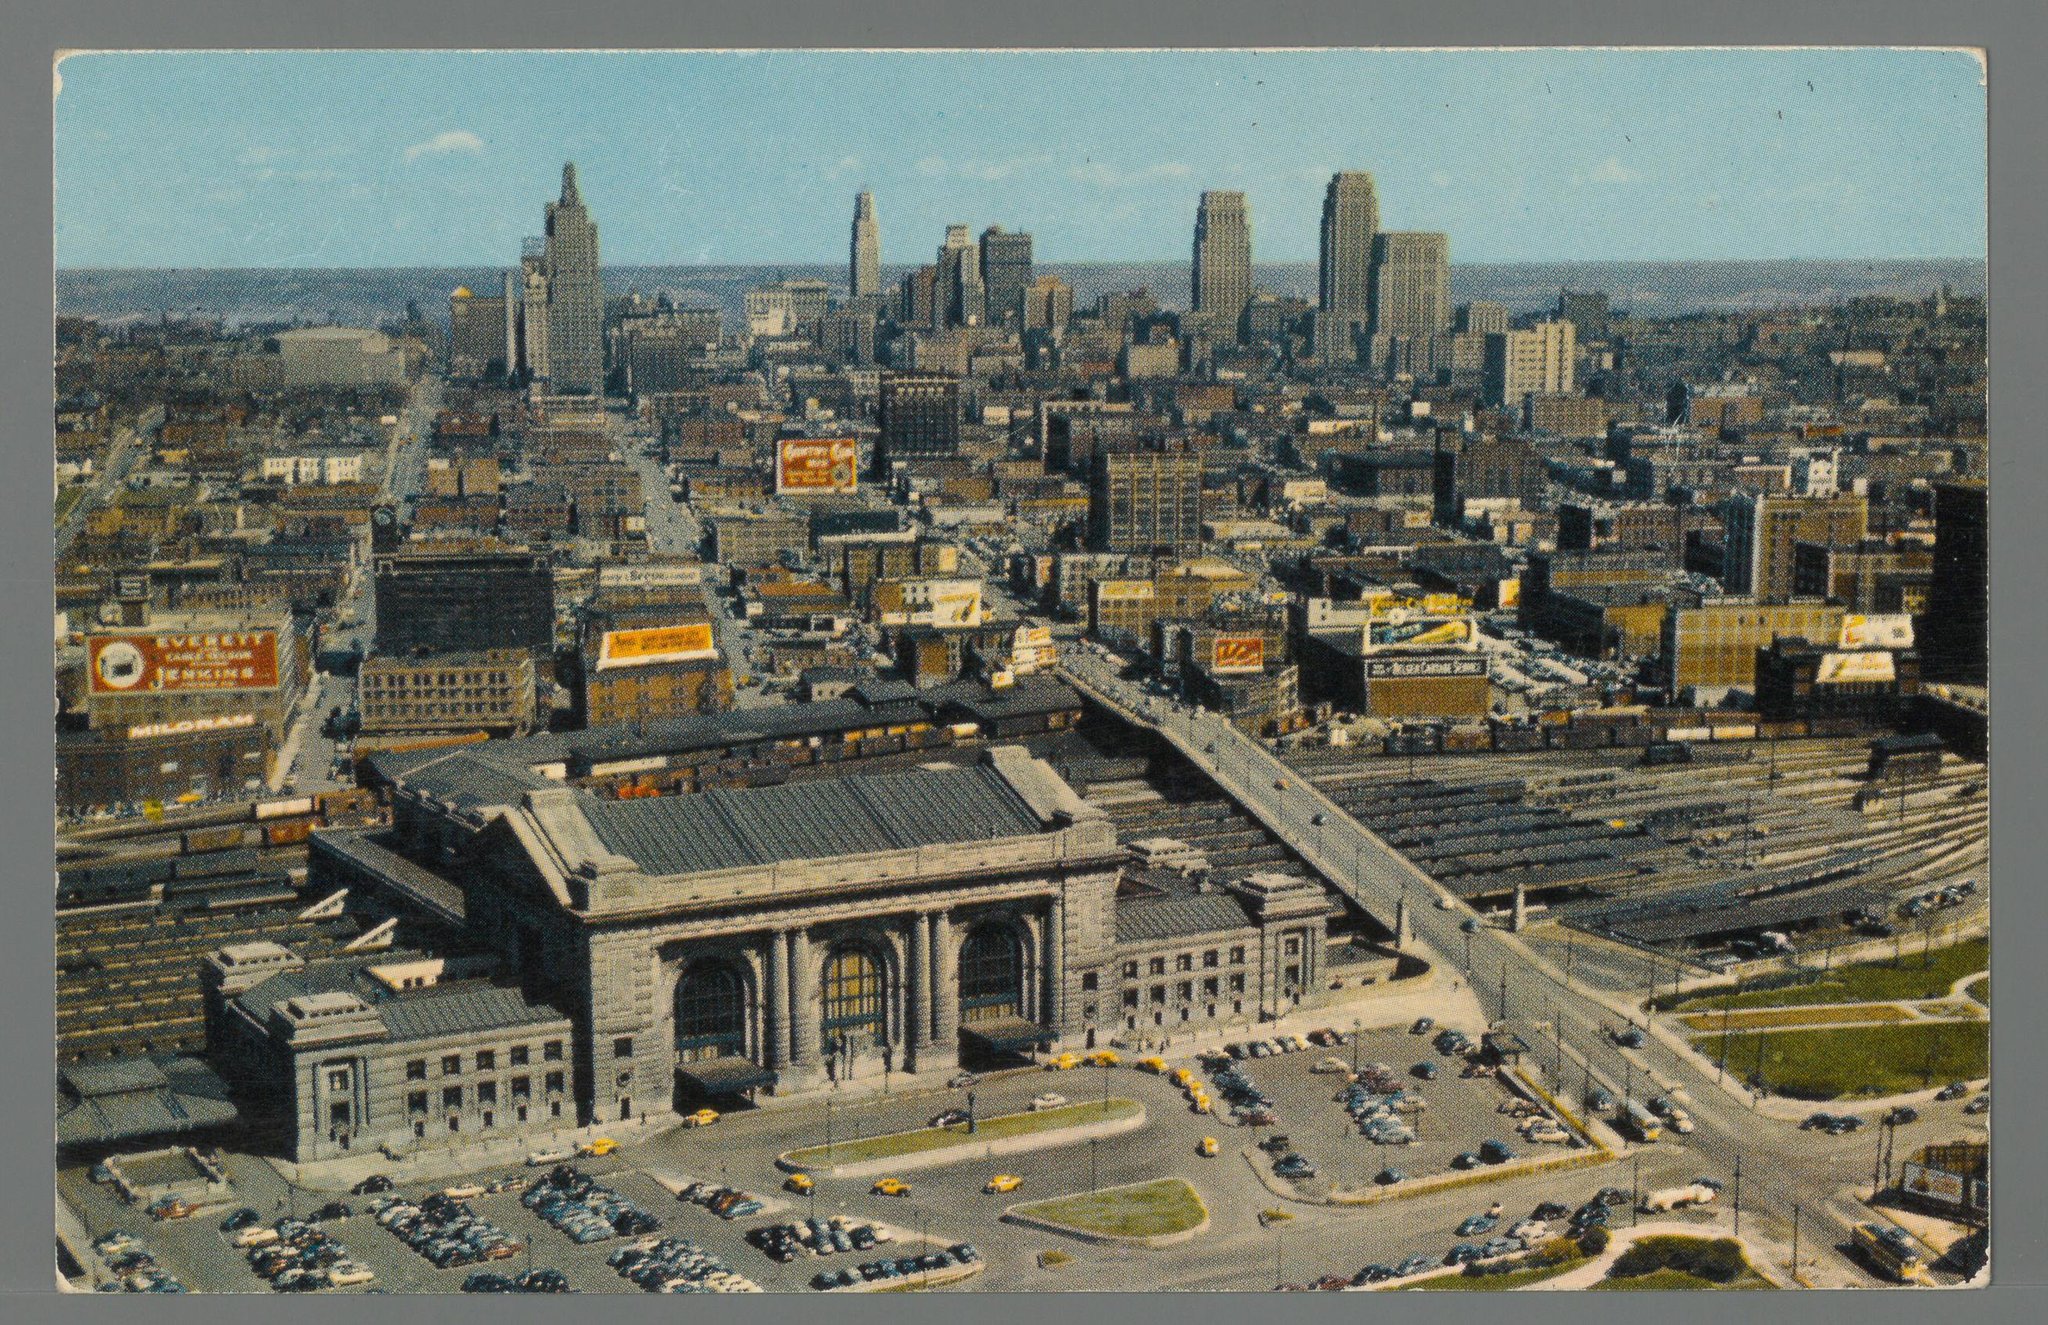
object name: ansichtkaart, prentbriefkaart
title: Union Station and Sky Line, Kansas City, Missouri (...)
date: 1950-1954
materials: cardboard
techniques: offset printed, writing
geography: san francisco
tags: city-view in general; 'veduta', platform (railway, tramway)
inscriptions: postage stamp